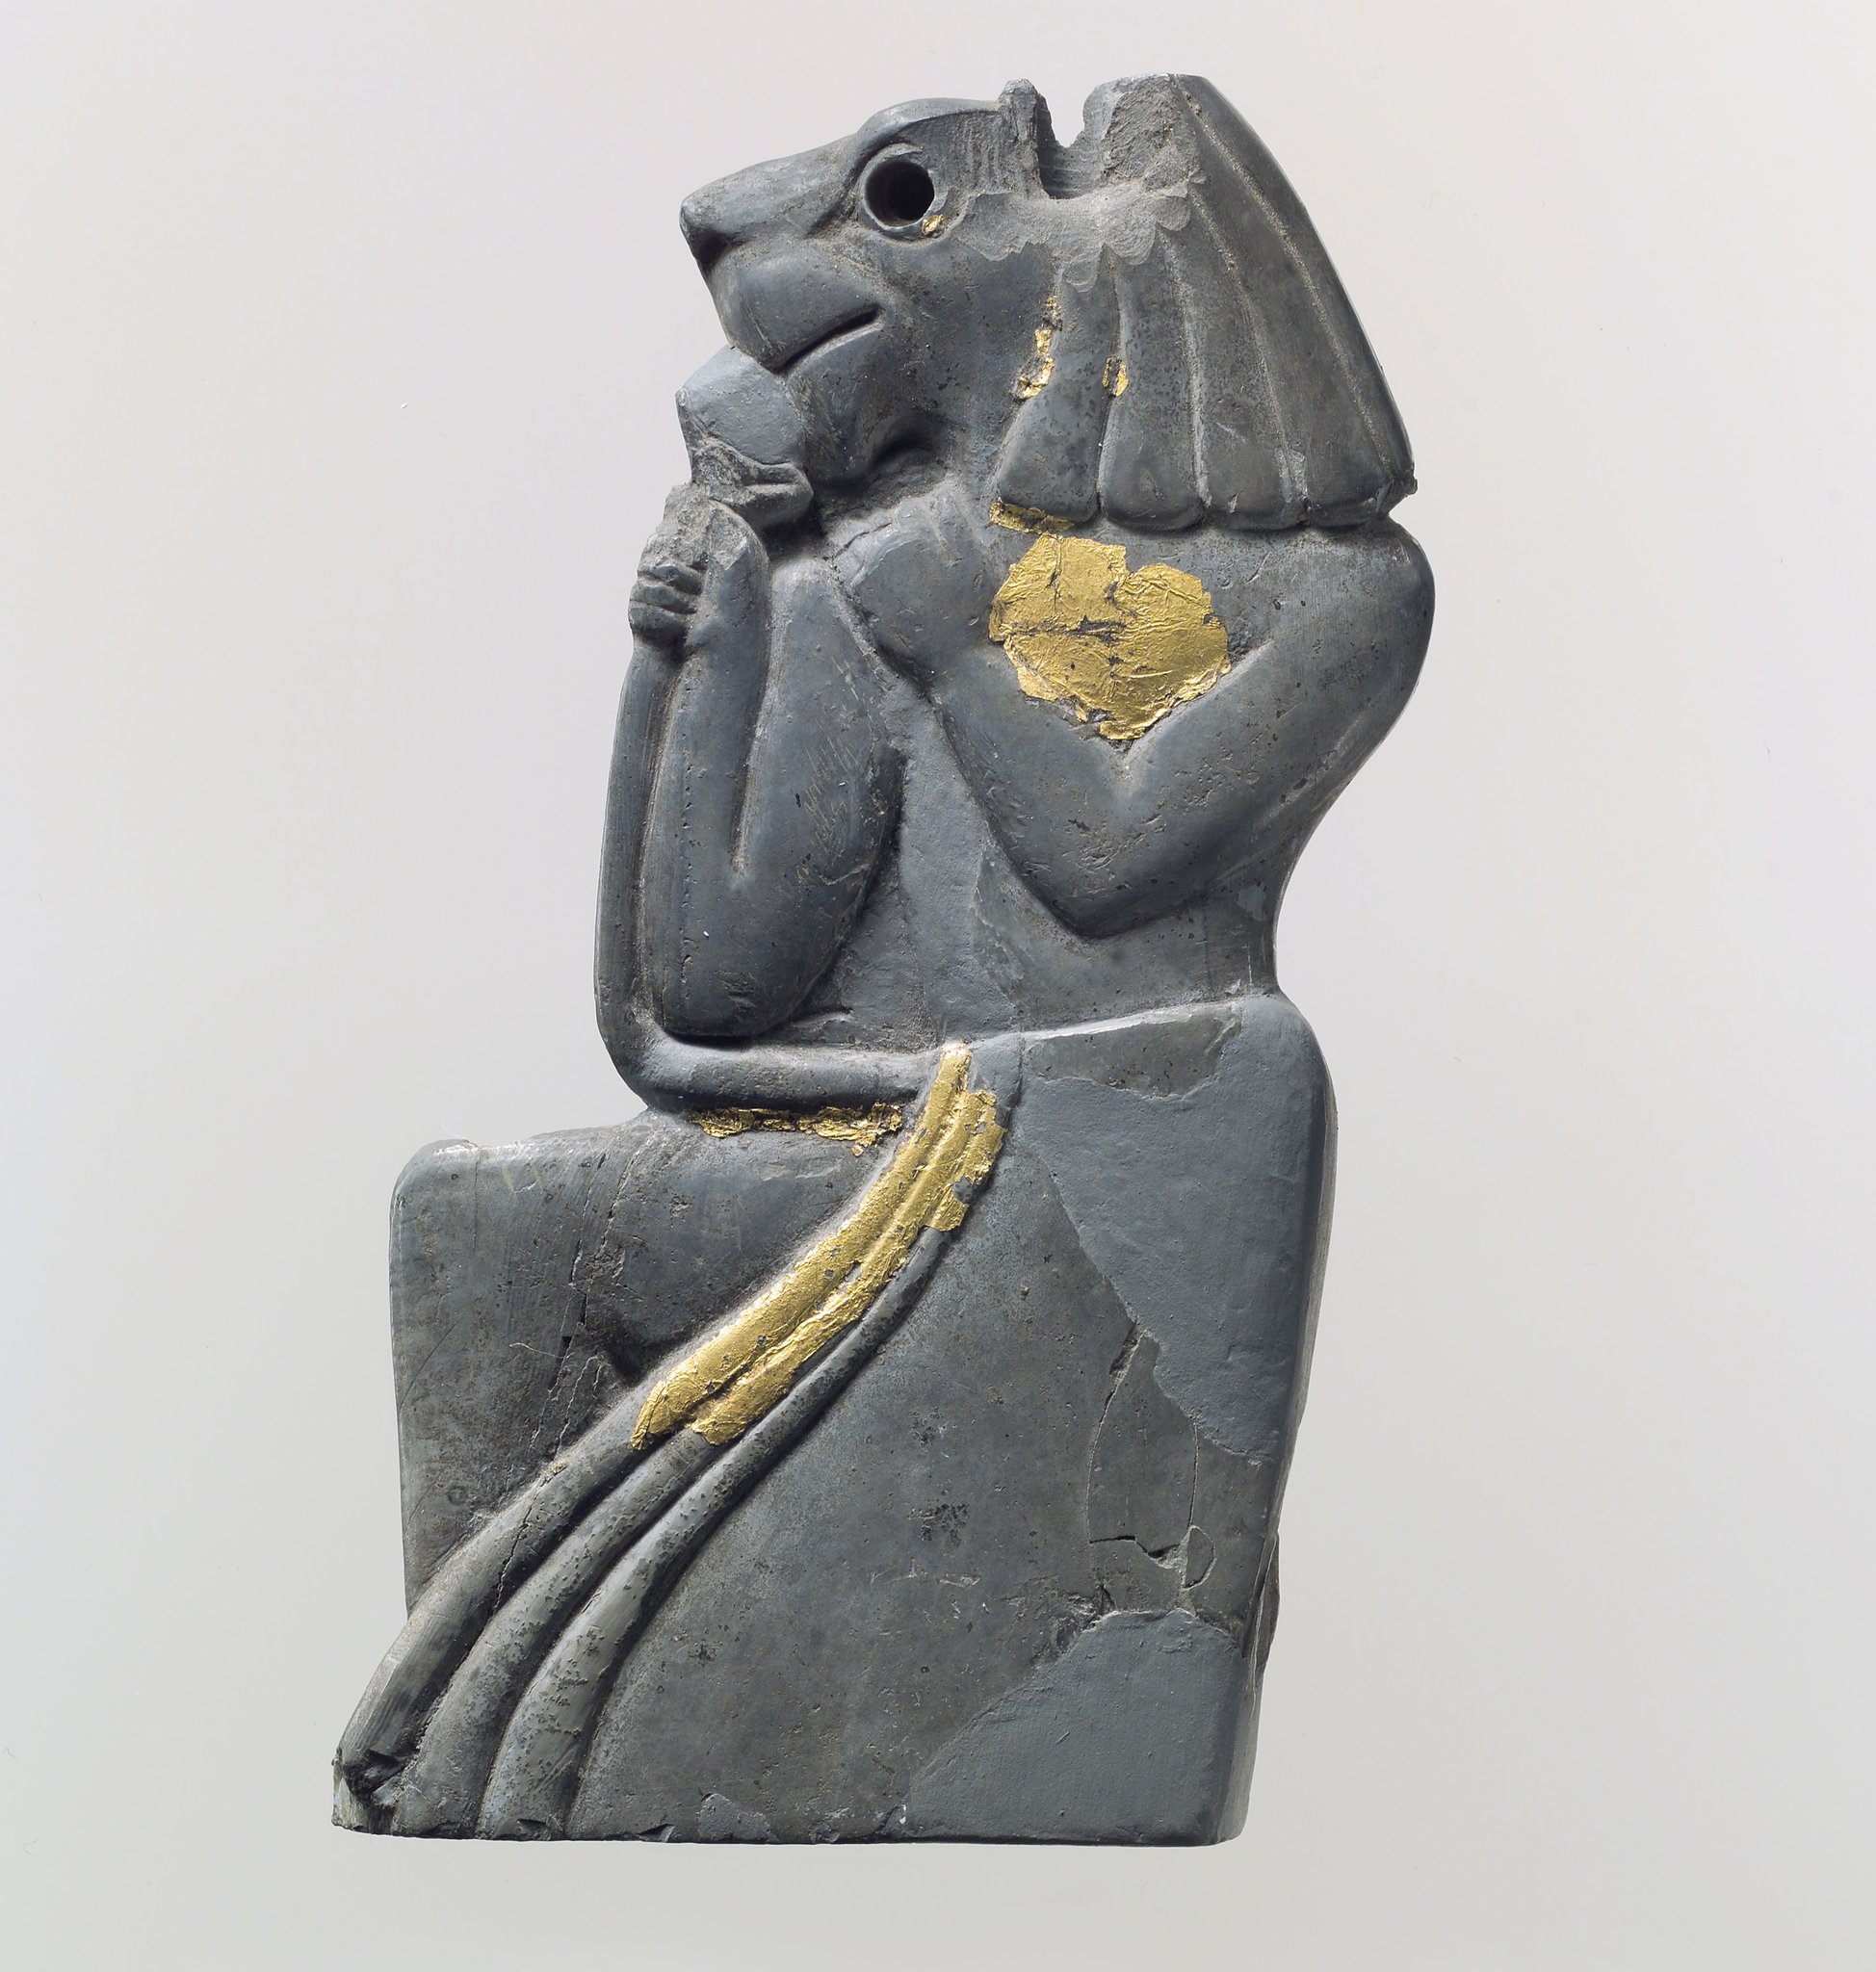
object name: relief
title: Plaque fragment: kneeling lion-headed figure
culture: assyrian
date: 1800-1701 BCE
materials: gold foil, ivory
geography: anatolia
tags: lions